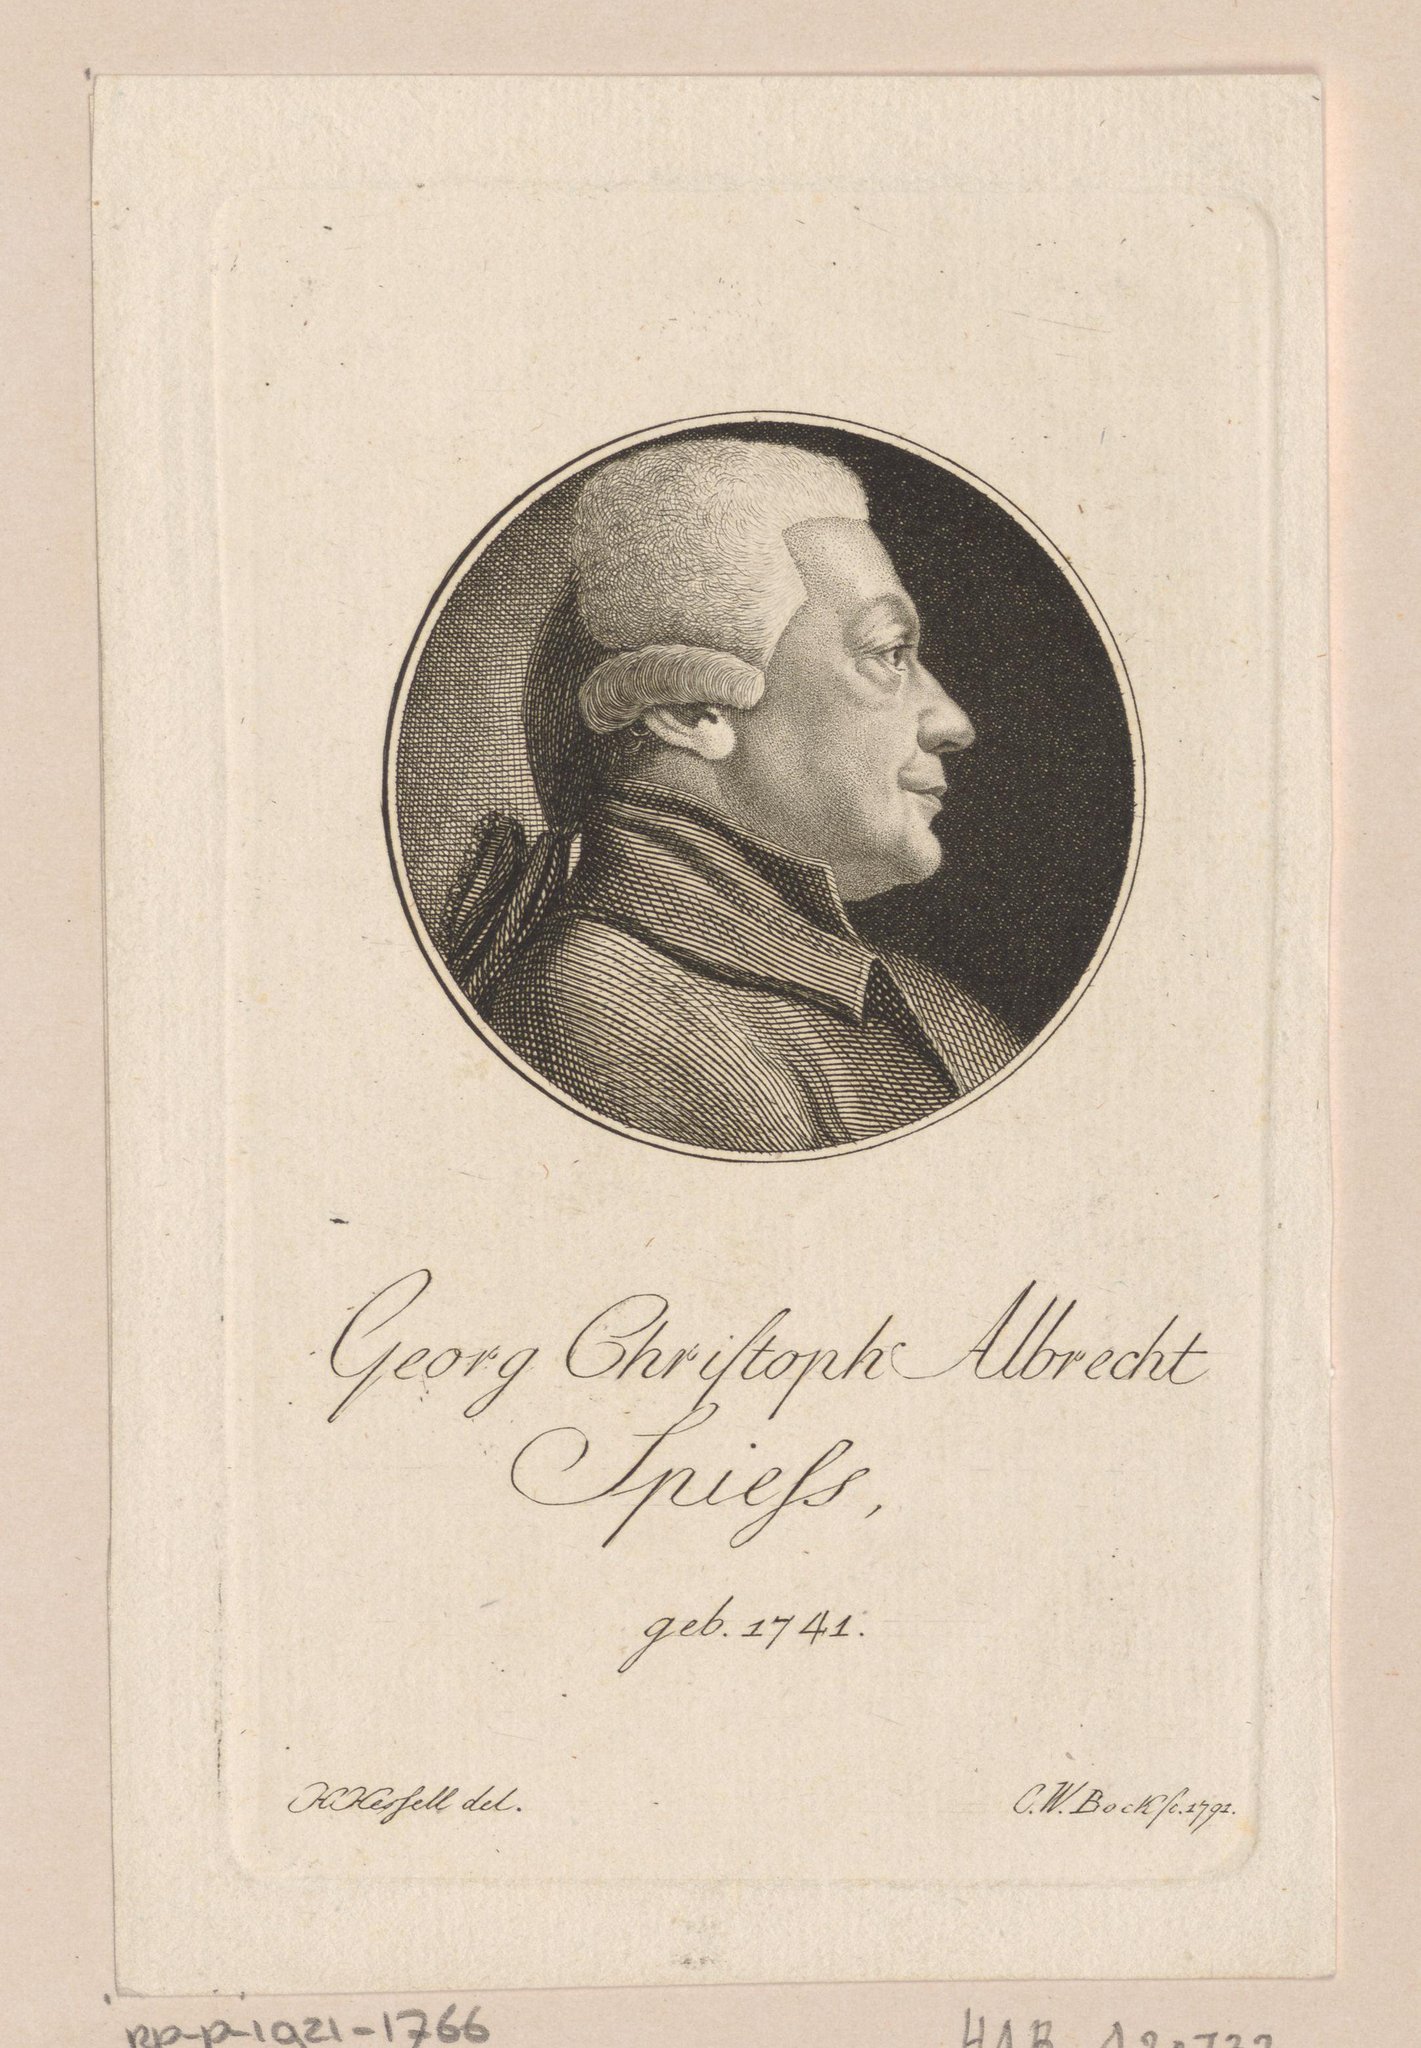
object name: print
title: Portret van Georg Christoph Albrecht Spieß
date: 1791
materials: paper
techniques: engraving, etching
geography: nuremberg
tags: historical persons, lawyer, attorney at law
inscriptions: collector's mark: Lugt 2233